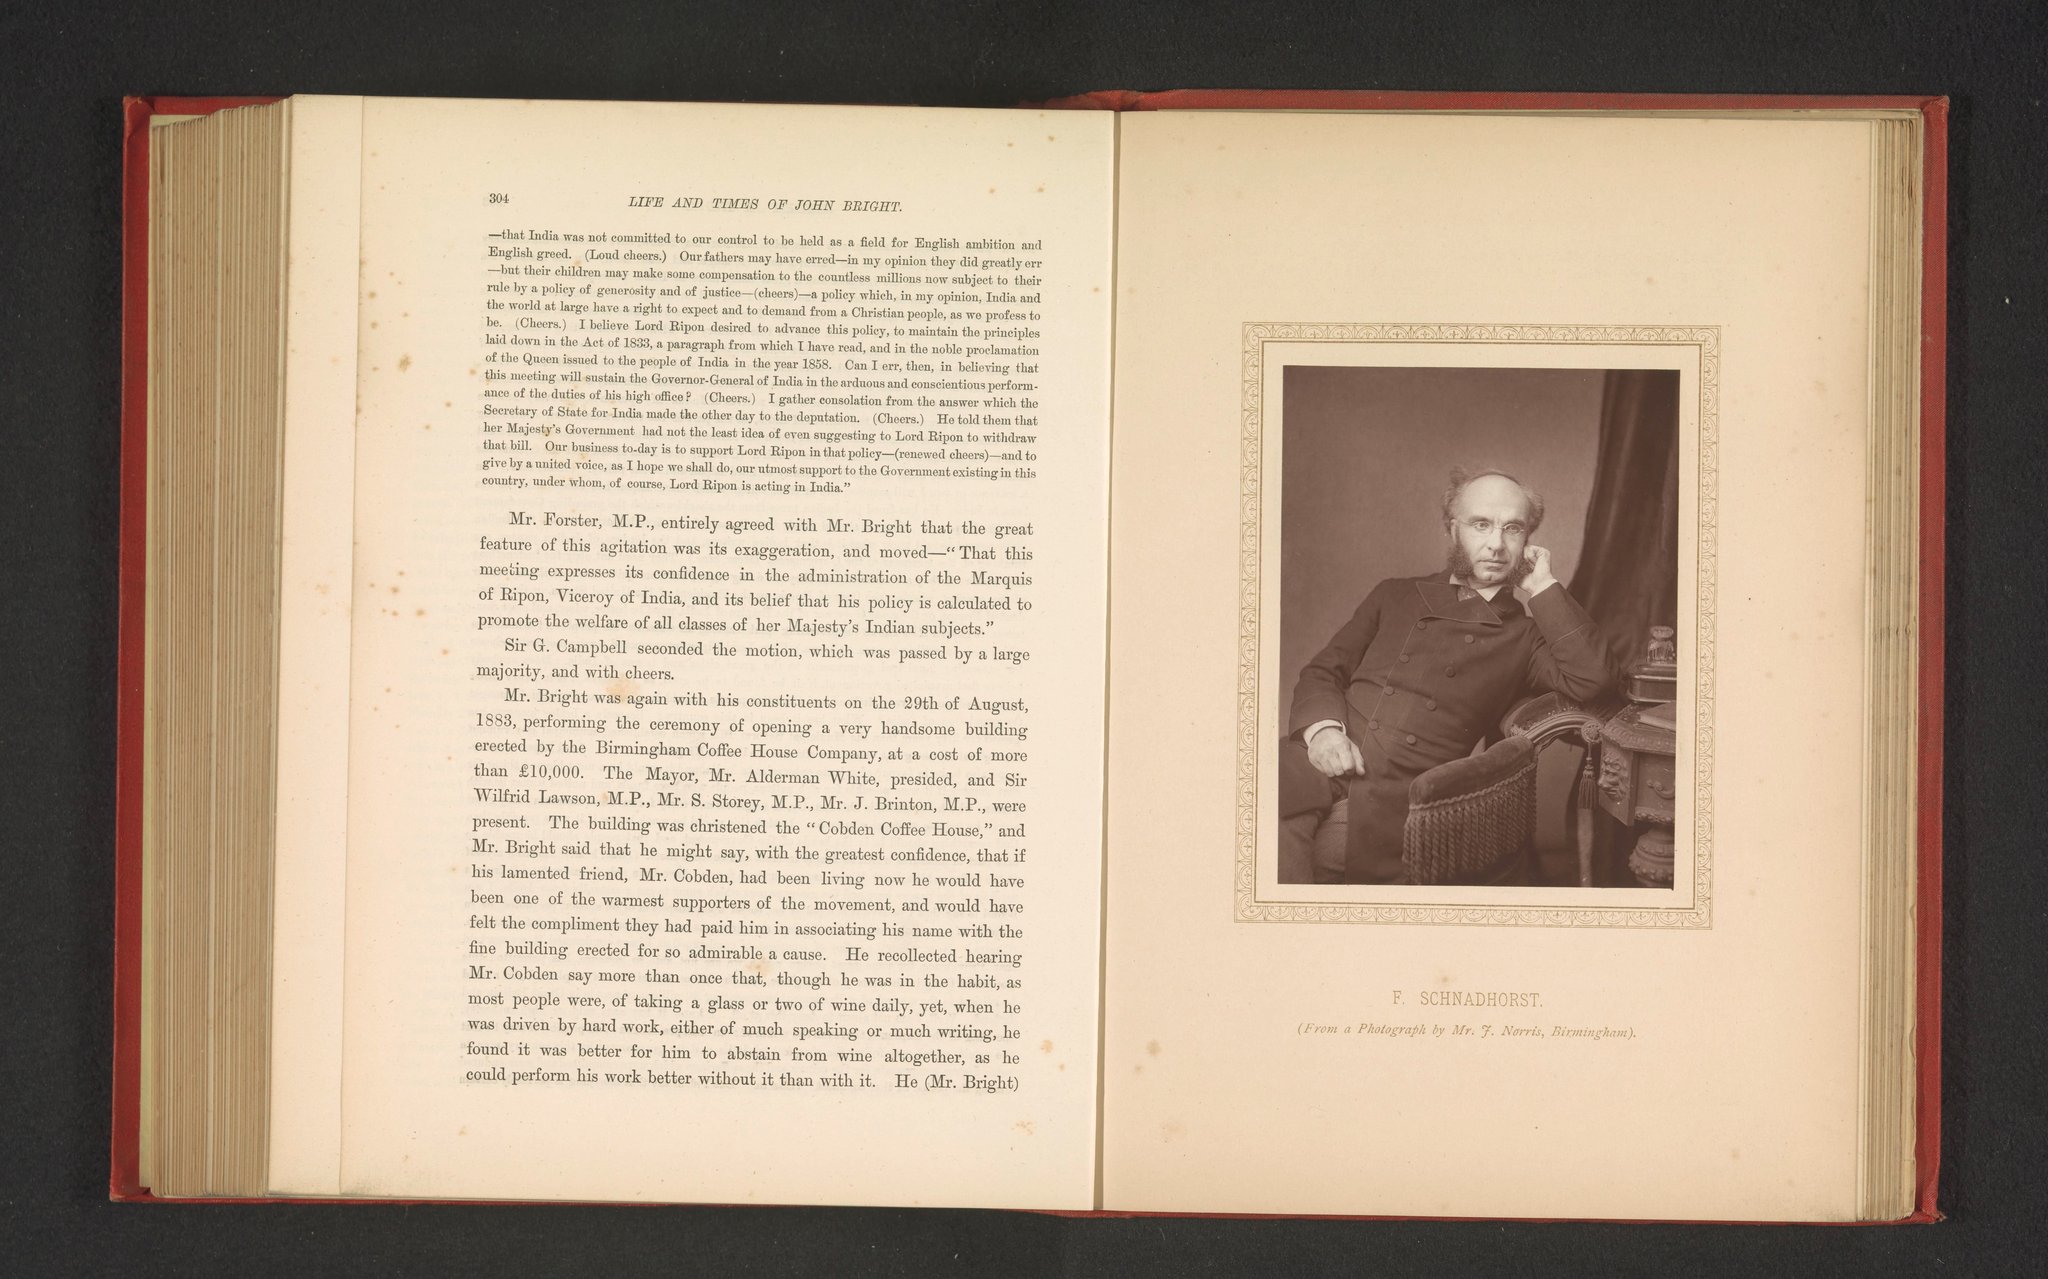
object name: photomechanical print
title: F. Schnadhorst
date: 1874-1884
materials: paper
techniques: woodburytype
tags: politician, politician, e.g. party leader